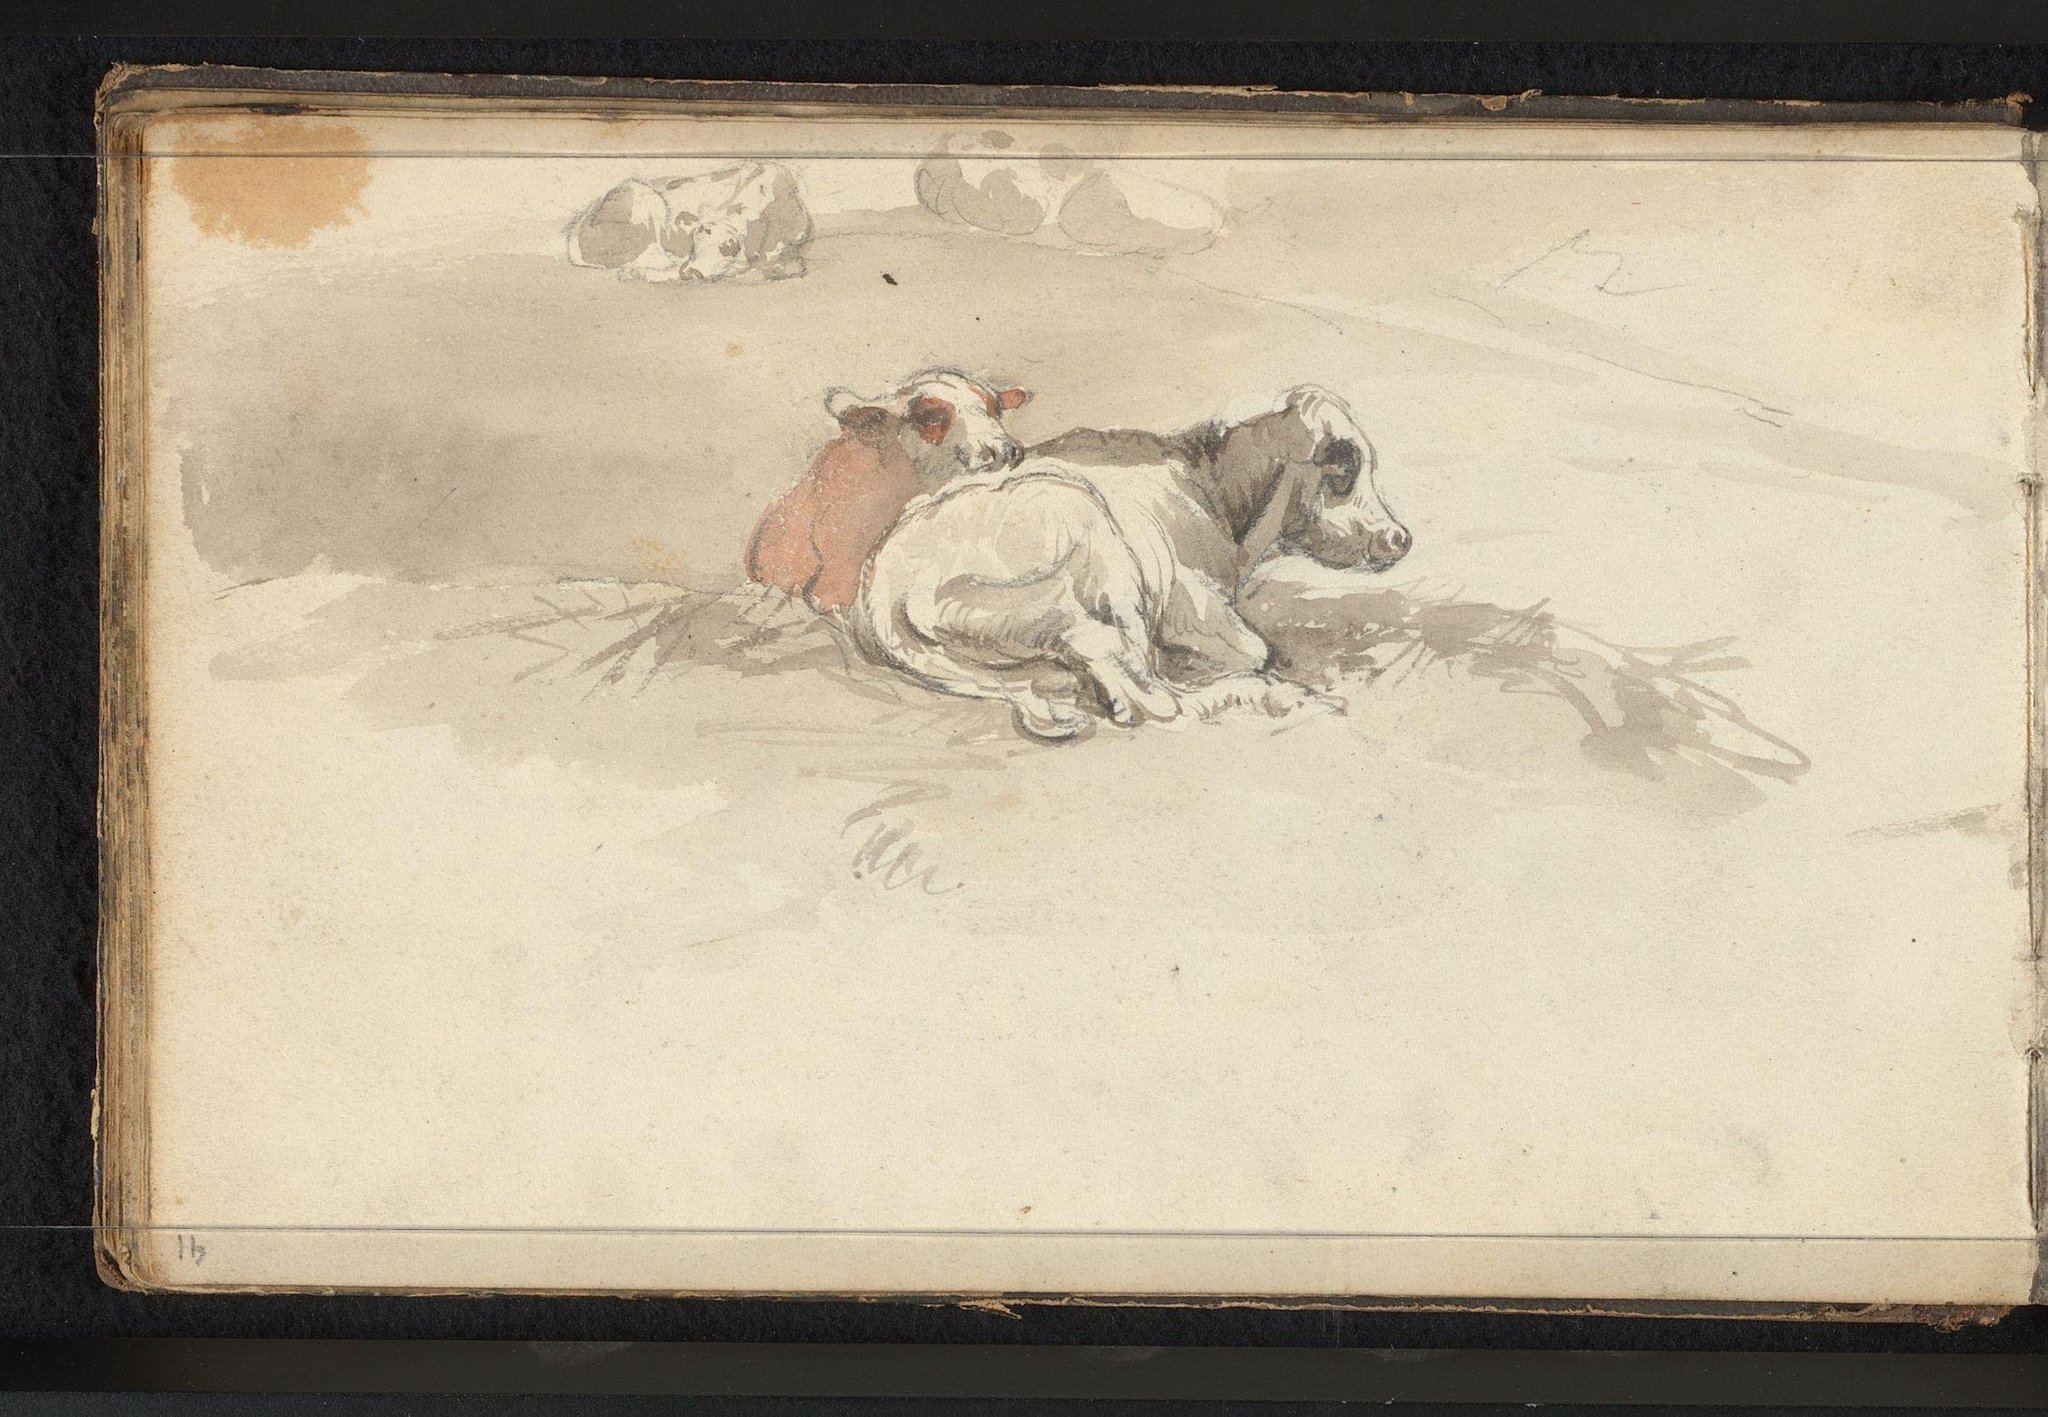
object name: sketchbook leaf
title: Runderen in een weiland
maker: jan bedijs tom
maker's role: draughtsman, painter, print maker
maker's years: 1813-1894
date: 1828-1894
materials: paper, pencil, watercolor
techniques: brush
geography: the hague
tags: landscapes, meadow, pasture, artist (in general) making preliminary designs, sketching, bovine cattle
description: Pagina 41 recto uit een schetsboek met 54 bladen.